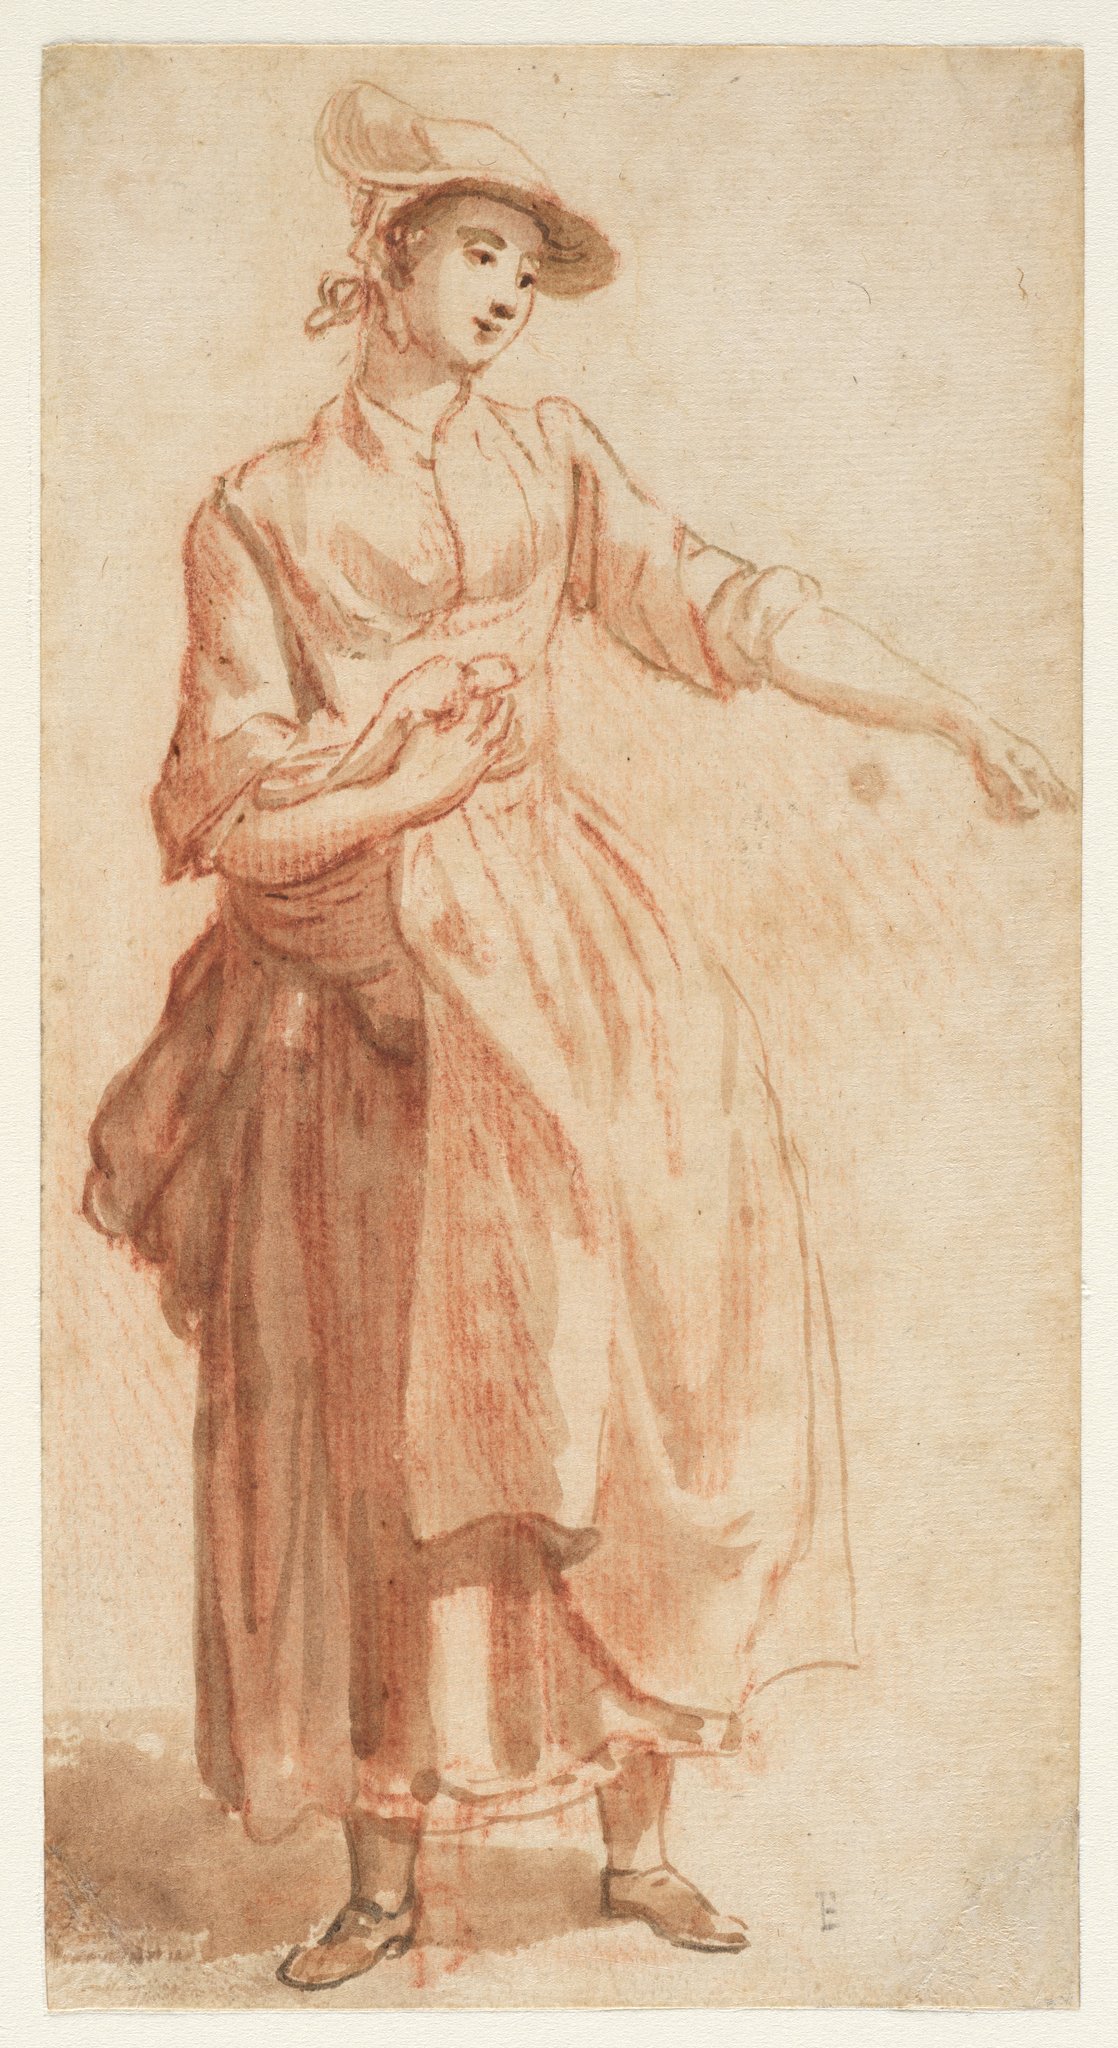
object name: drawing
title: A Young Woman, Full Length, with Her Left Arm Outstretched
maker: paul sandby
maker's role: artist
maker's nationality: british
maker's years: 1731-1809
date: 1770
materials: chalk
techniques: wash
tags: women